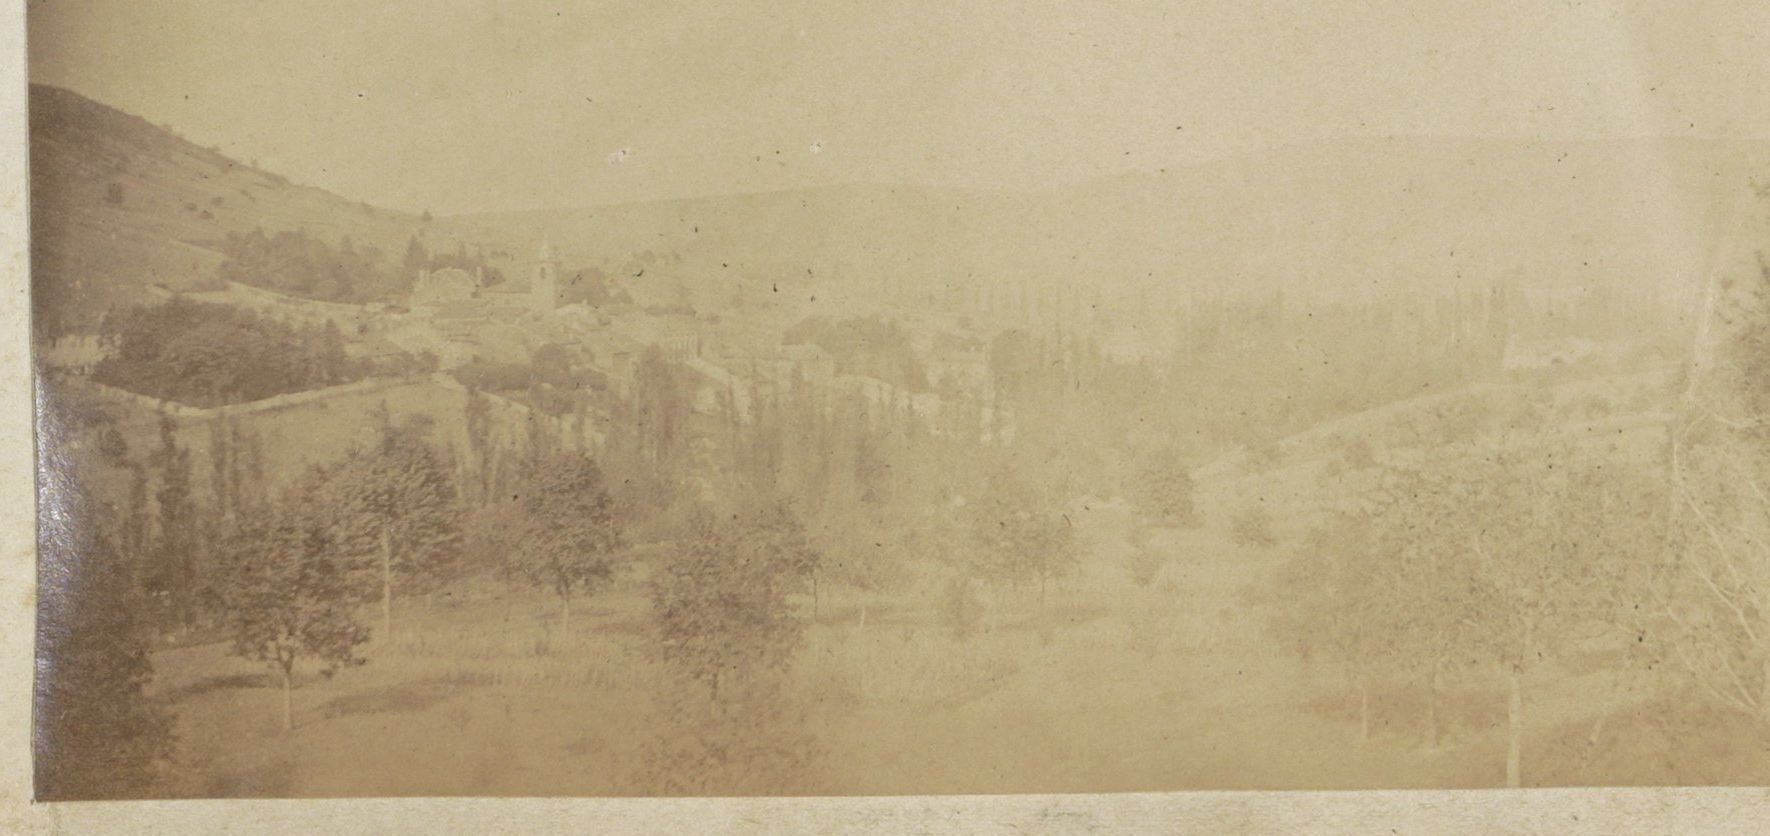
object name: photograph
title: Glooiend landschap met bomen in Frankrijk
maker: Anonymous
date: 1805-1884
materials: photographic support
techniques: albumen print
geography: france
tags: trees, landscapes in the temperate zone, france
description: Onderdeel van Album van een Franse amateurfotograaf met opnames van familie, militairen, industrie, landschappen en bezienswaardigheden in Frankrijk.